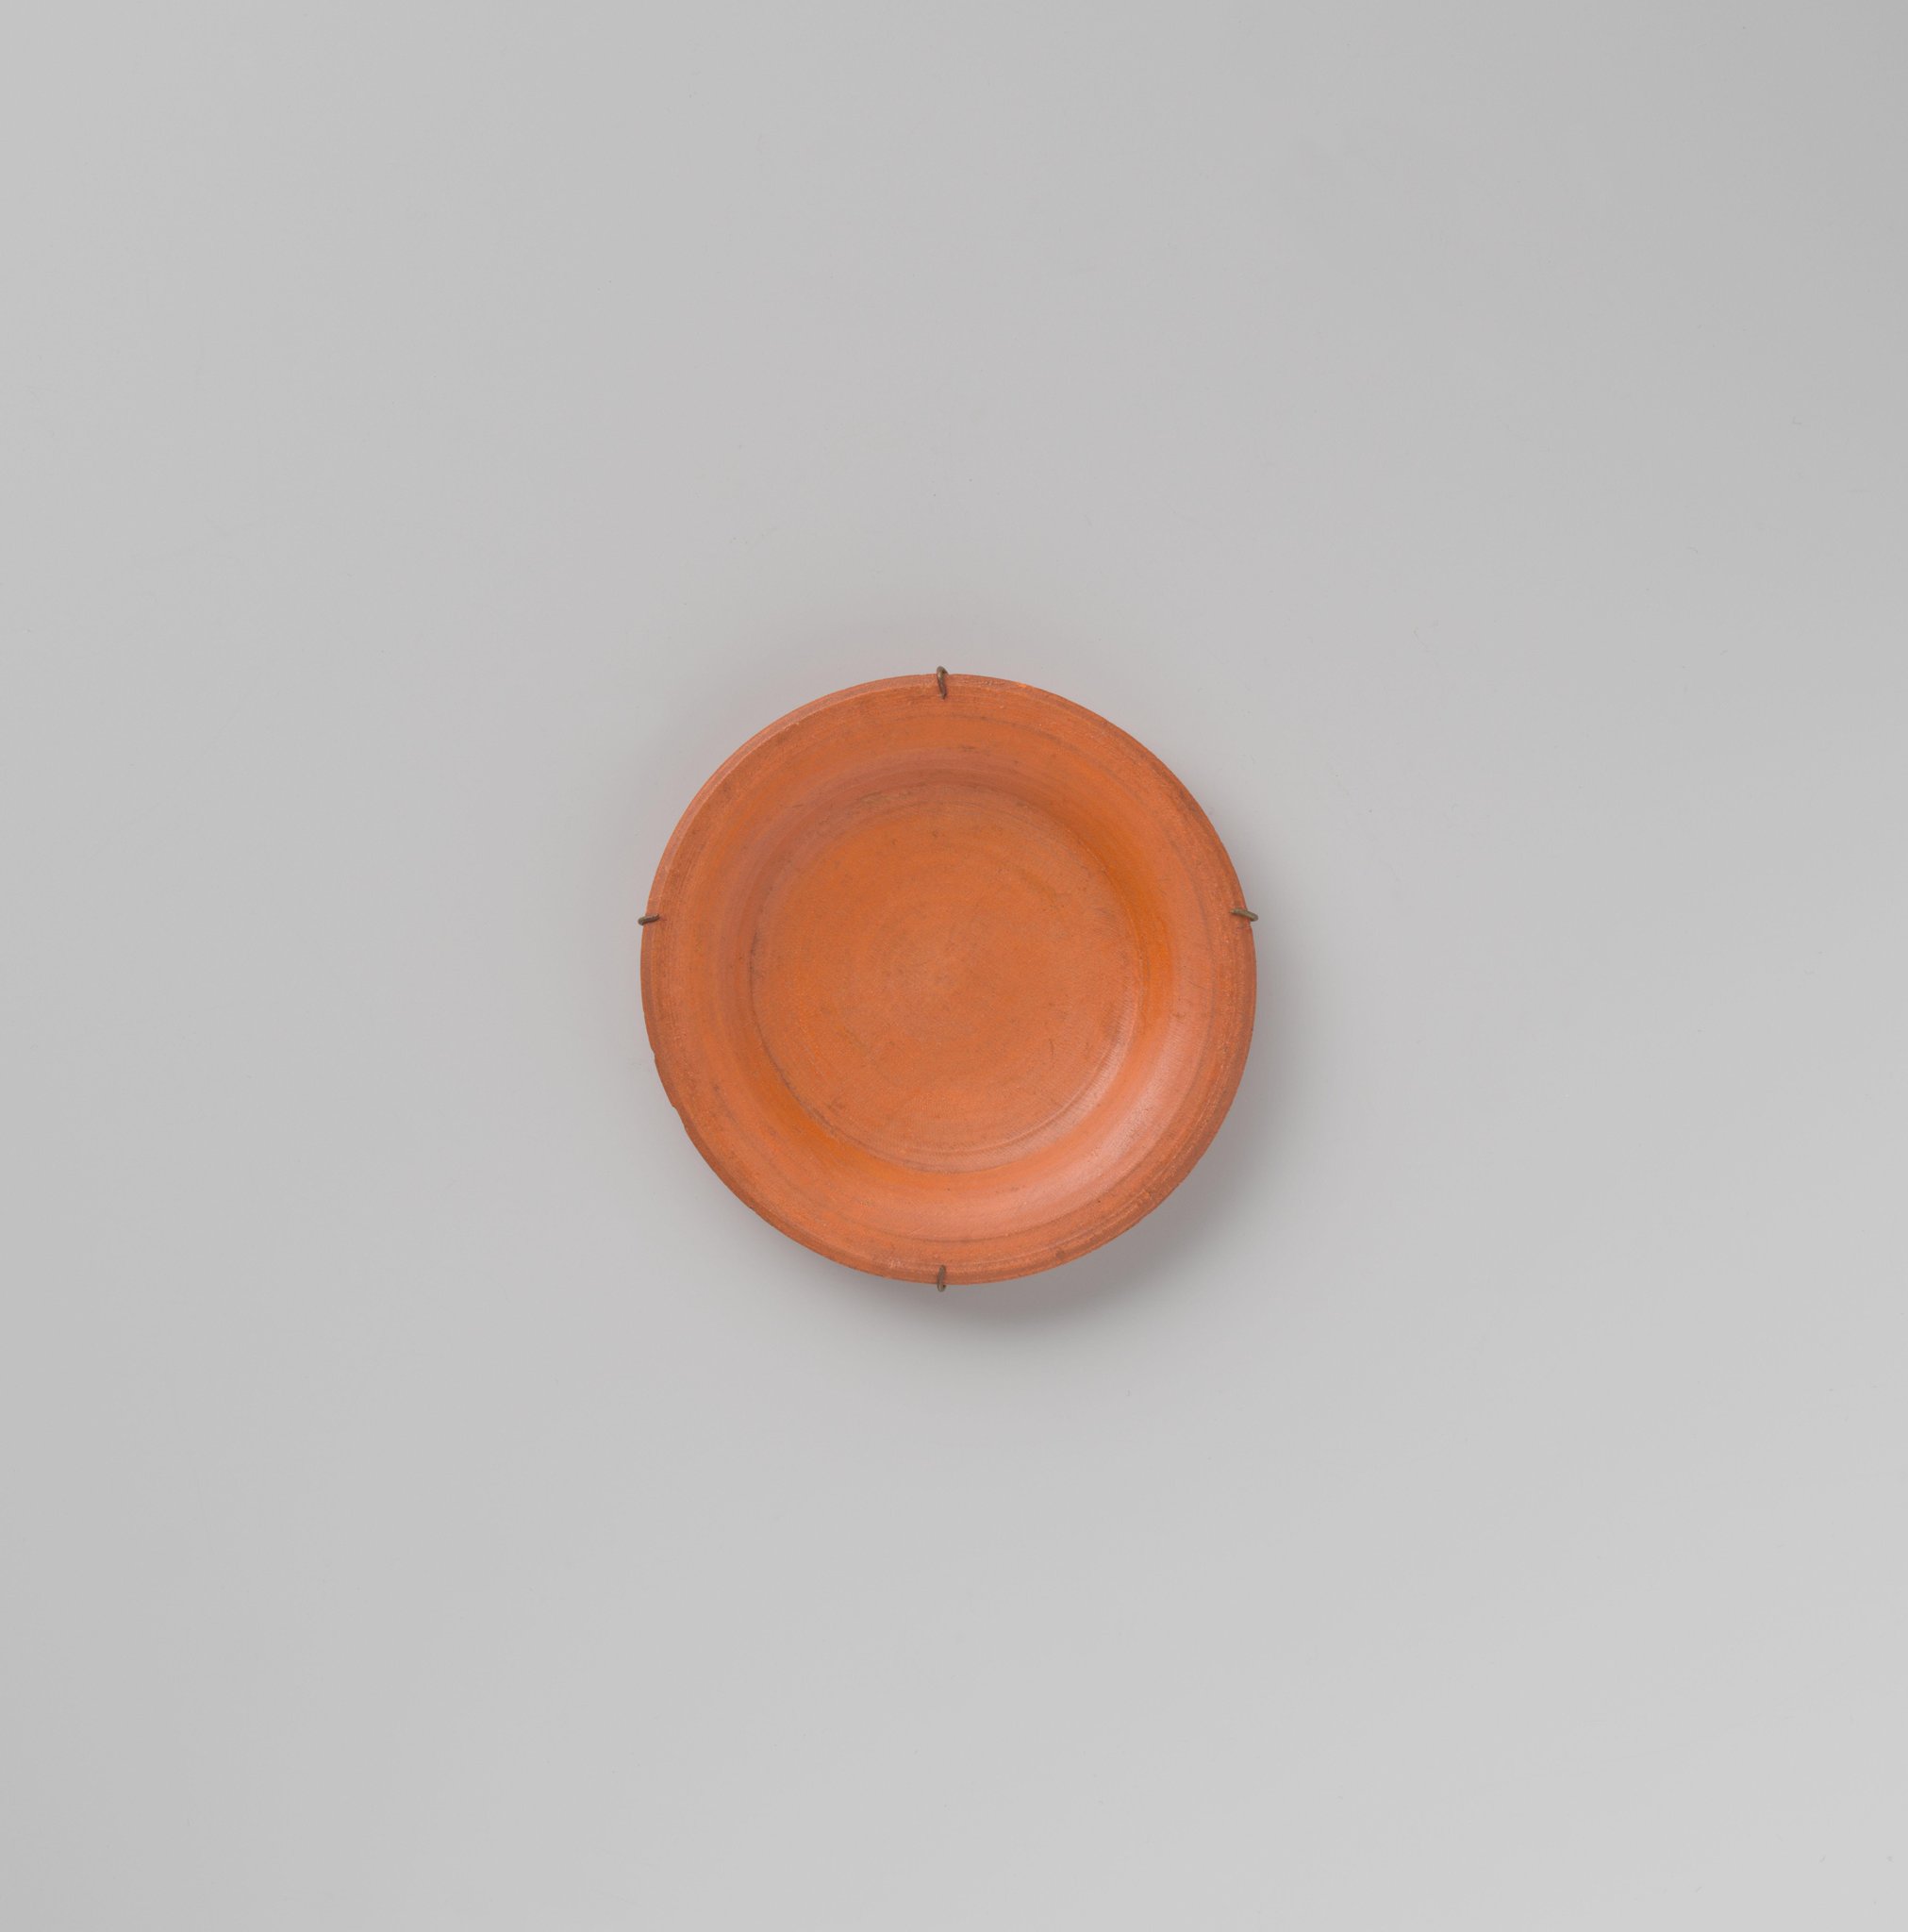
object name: miniature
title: Schotel van gedraaid, roodgeverfd hout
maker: Anonymous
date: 1675-1699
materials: wood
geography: amsterdam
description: Schotel van gedraaid, roodgeverfd hout. De schotel is gevat in klampen van koperdraad ter bevestiging.